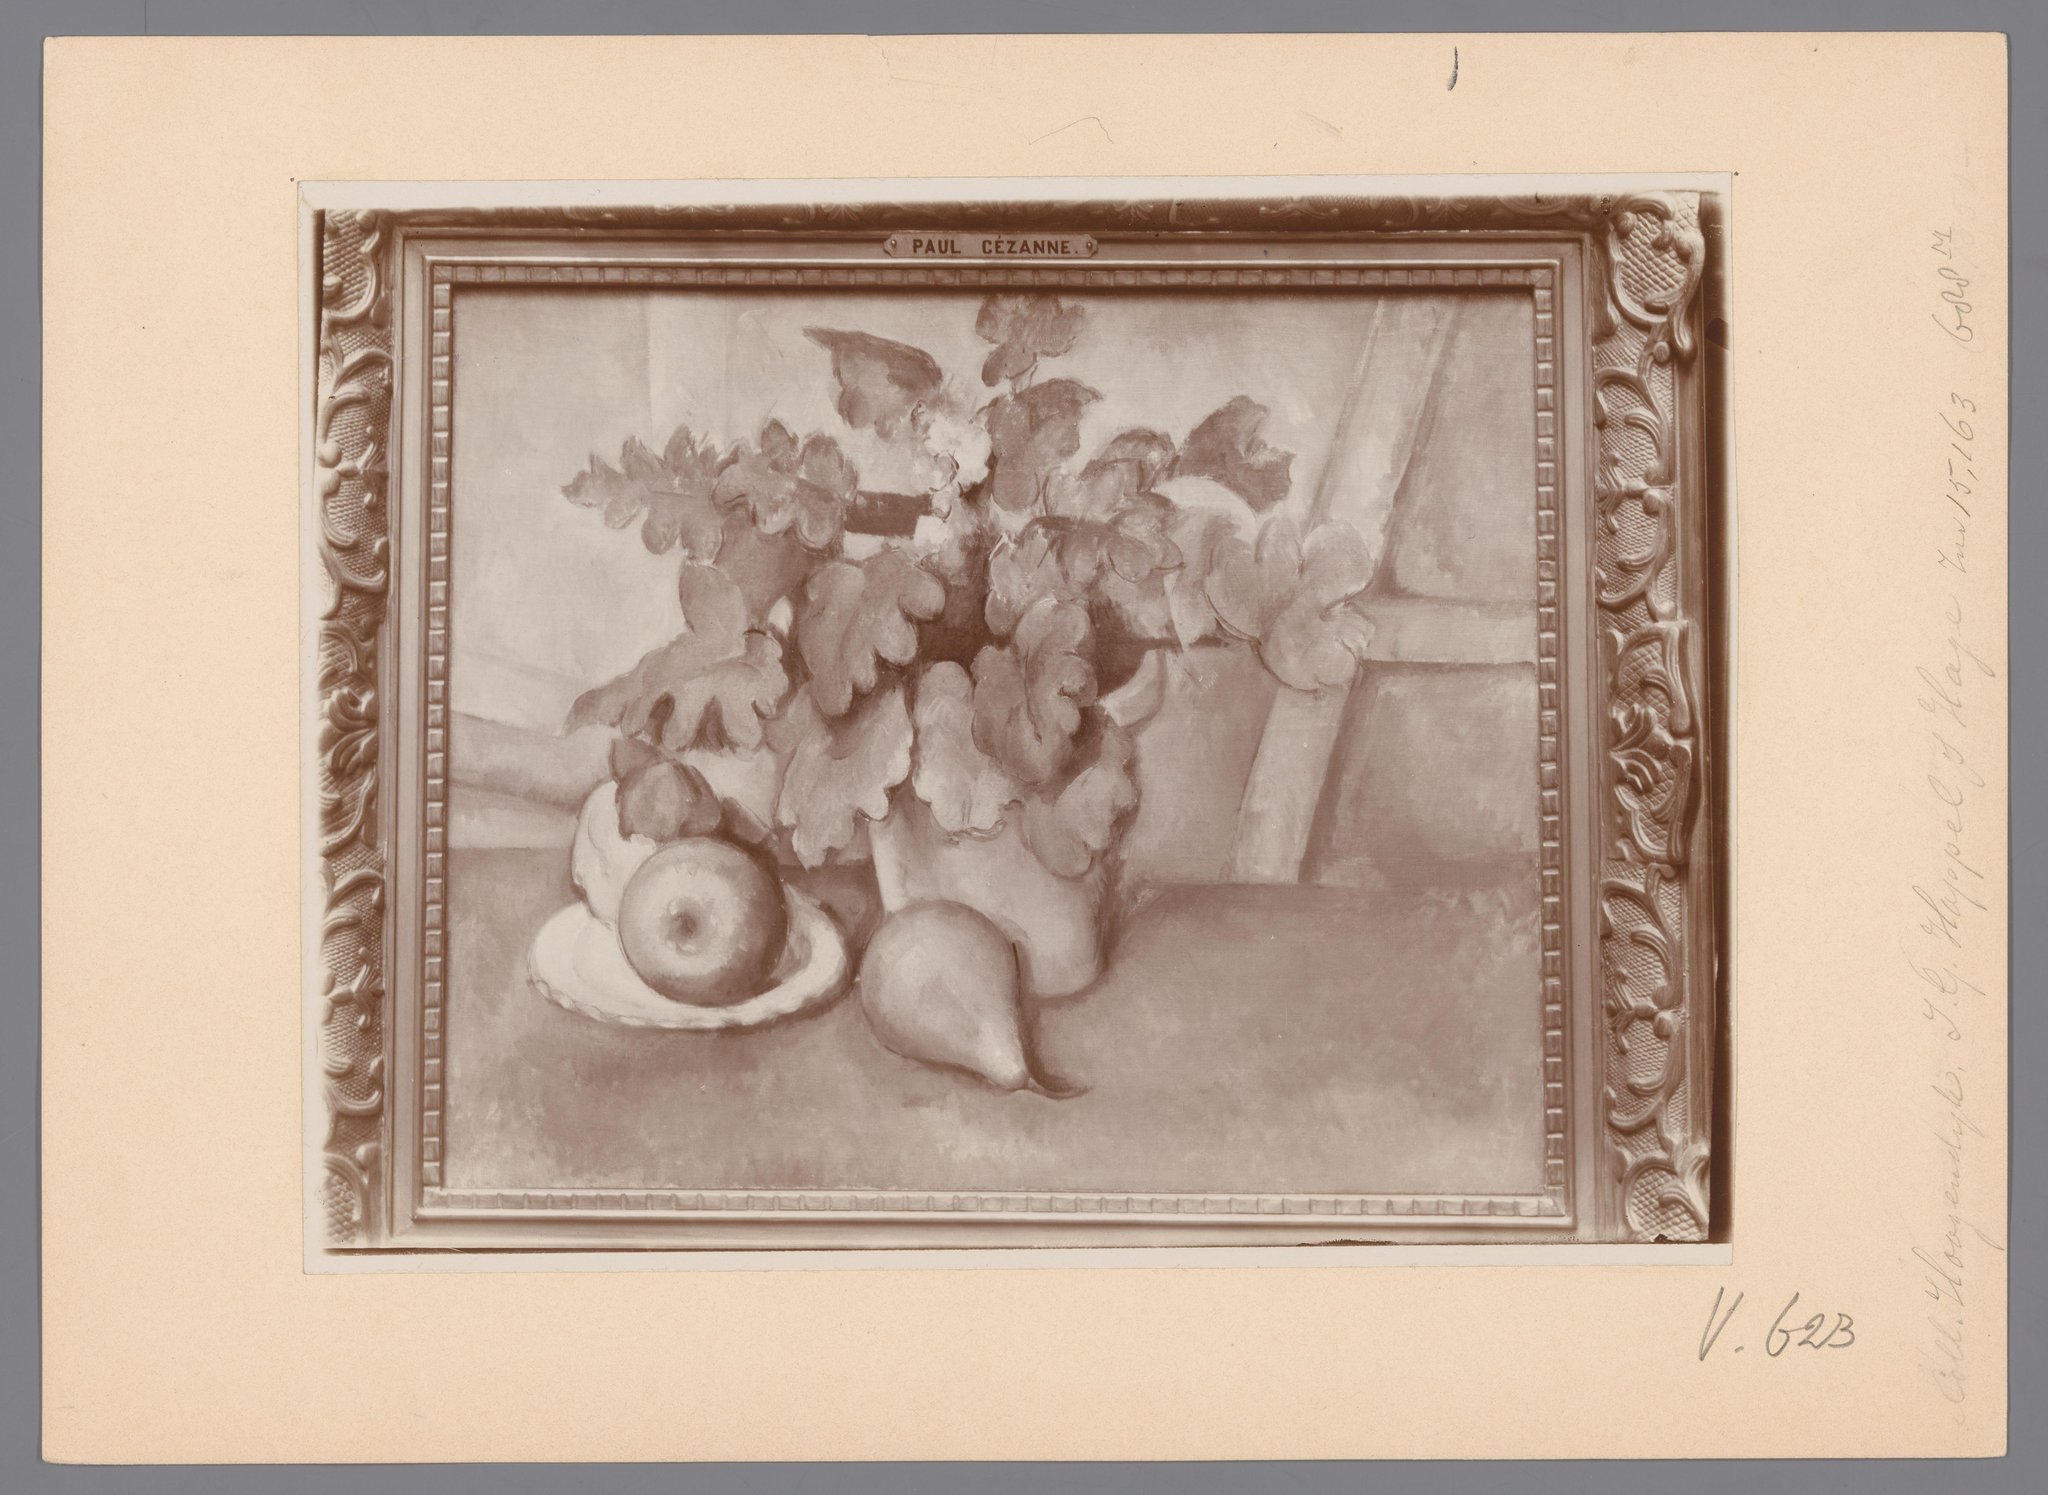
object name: photograph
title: Fotoreproductie van een schilderij met stilleven met fruit en plant door Paul Cézanne uit de collectie Hoogendijk, nu in de Courtauld Gallery, Londen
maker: johannes gerardus happel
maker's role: publisher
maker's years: 1854-1928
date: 1915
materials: paper, cardboard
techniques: gelatin silver print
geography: the hague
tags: plants (in general), still life of related objects, picture, painting, fruits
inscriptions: inscription: ‘V. 623’, inscription: ‘Coll. Hoogendijk J.G. Hapel 's Hage Inv 15,163 688M’, collector's mark: Lugt 2228, inscription: ‘15,163’